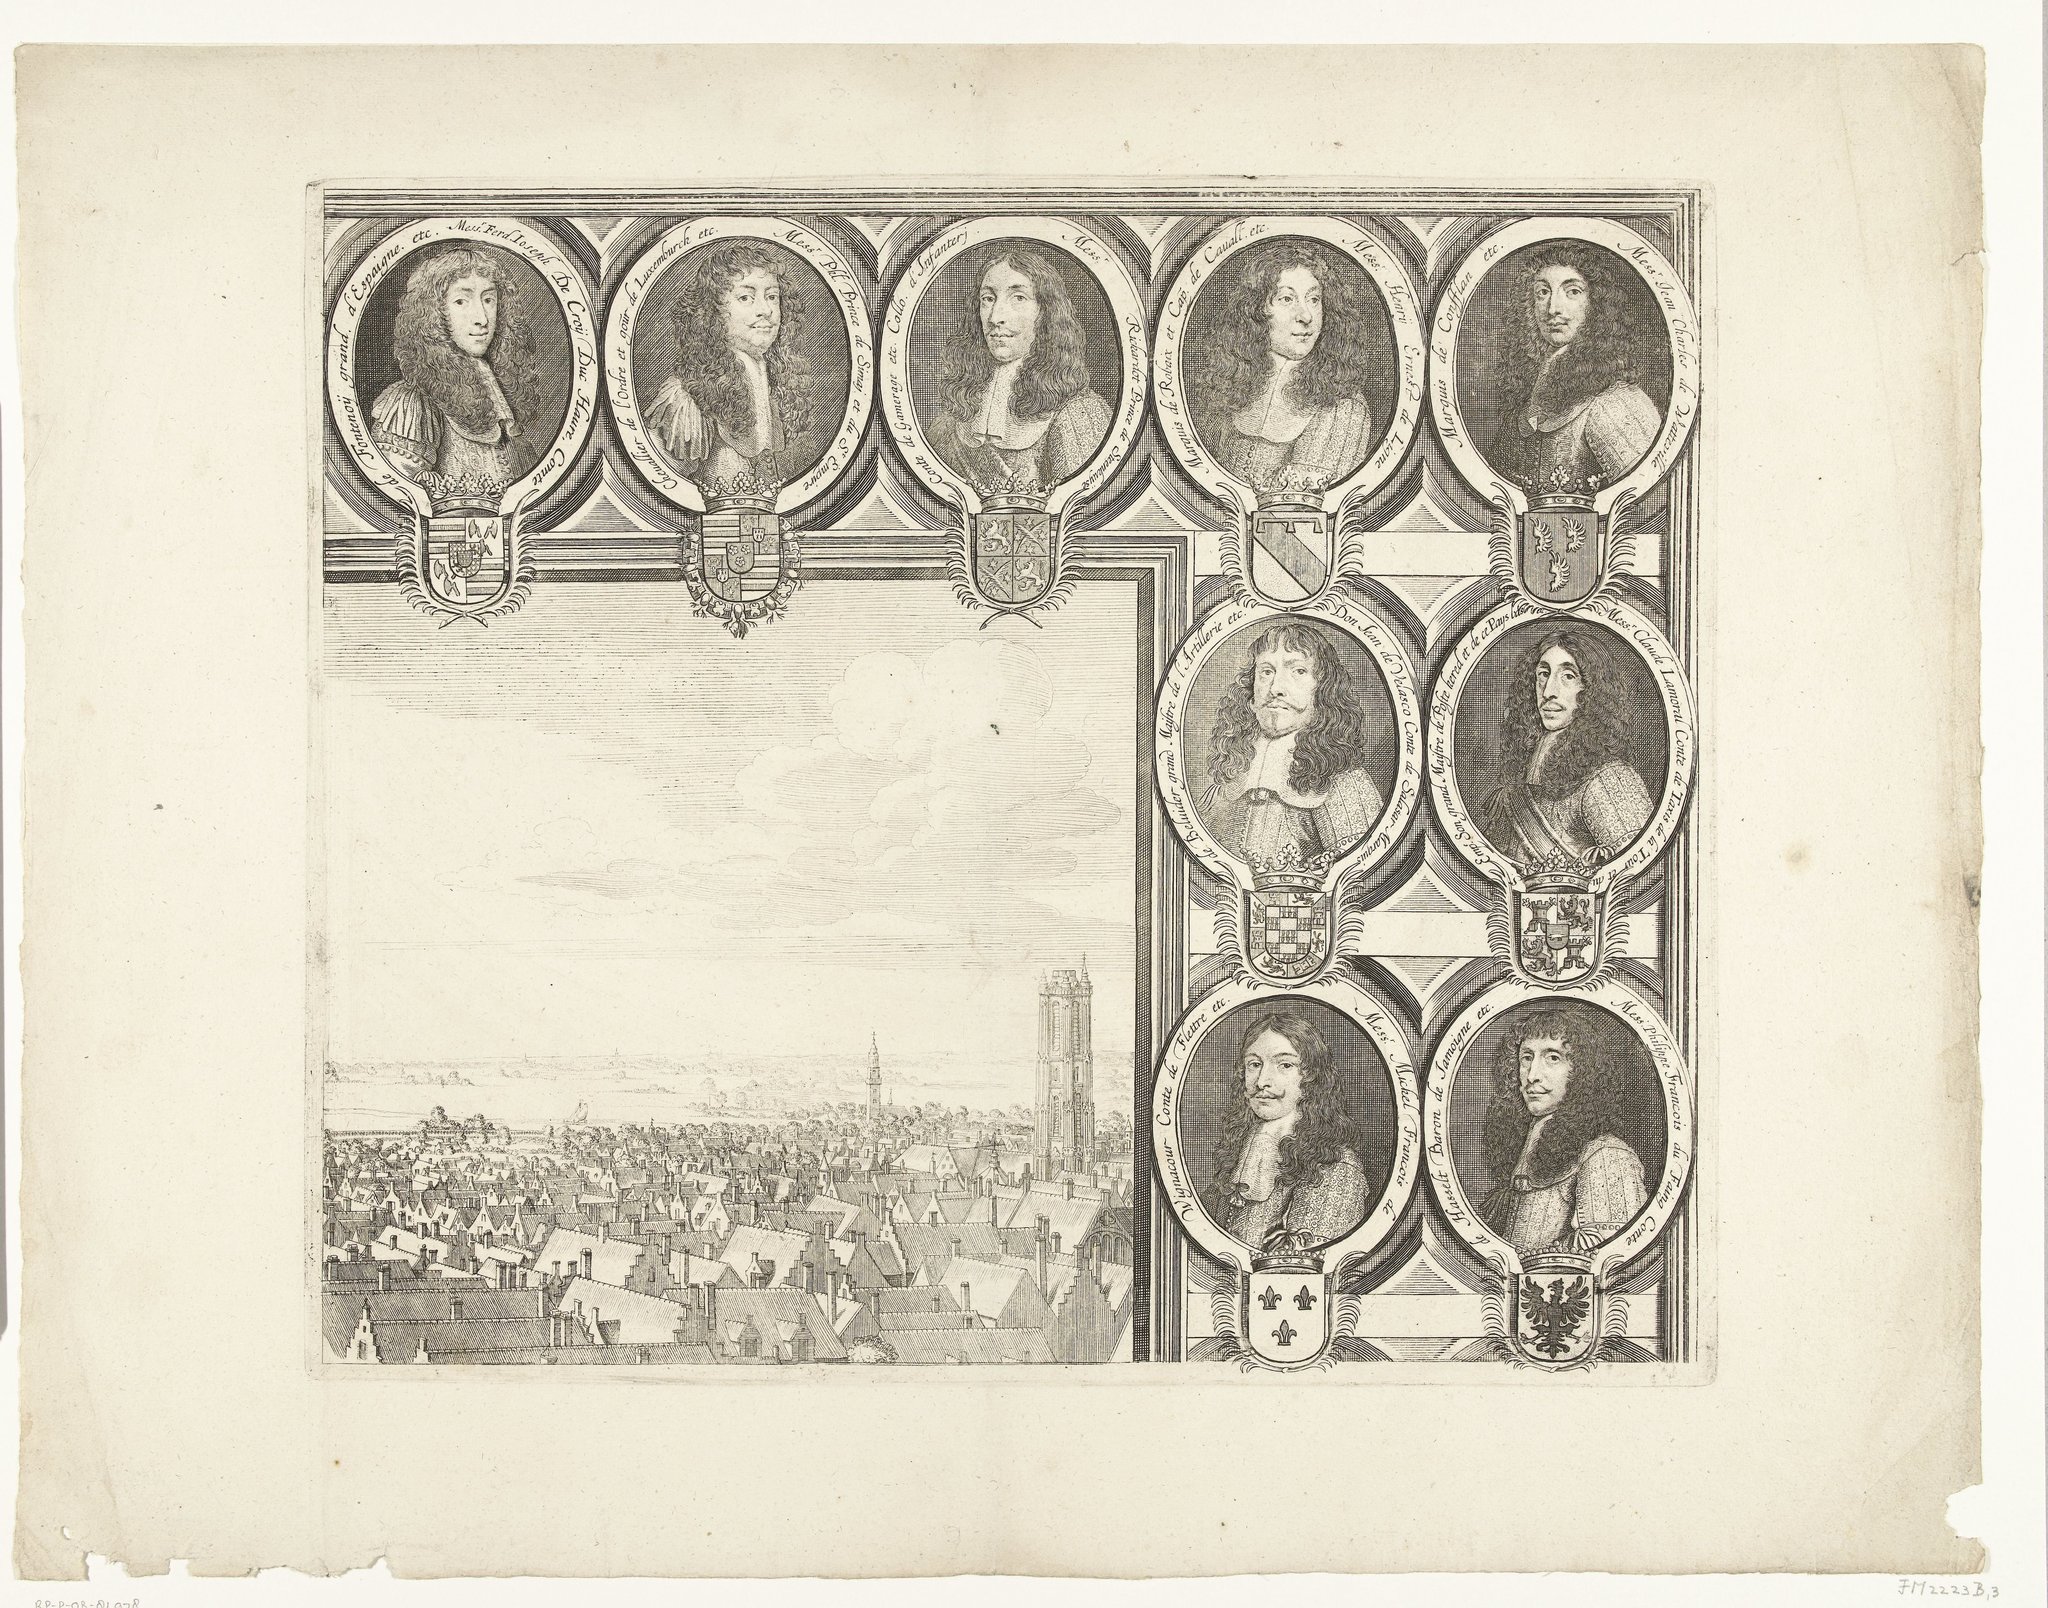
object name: print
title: Proclamatie te Gent van Karel II van Spanje als graaf van Vlaanderen (blad 3), 1666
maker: lucas vorsterman (ii)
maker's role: print maker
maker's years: 1624-1667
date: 1666-1667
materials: paper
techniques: engraving, etching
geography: southern netherlands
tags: karel ii (koning van spanje), ceremonial procession, parade, pageant ~ installation of a ruler, festivities (+ parade, pageant, cavalcade ~ festive activities)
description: Ceremonie op de Vrijdagmarkt te Gent bij de proclamatie van de Spaanse koning Karel II als graaf van Vlaanderen, 2 mei 1666. Blad 3 in een ongemonteerde ensemble van 12 platen van de ceremonie en cavalcade op het plein en 118 portretten van de hoogwaardigheidsbekleders die bij de plechtigheid aanwezig waren.